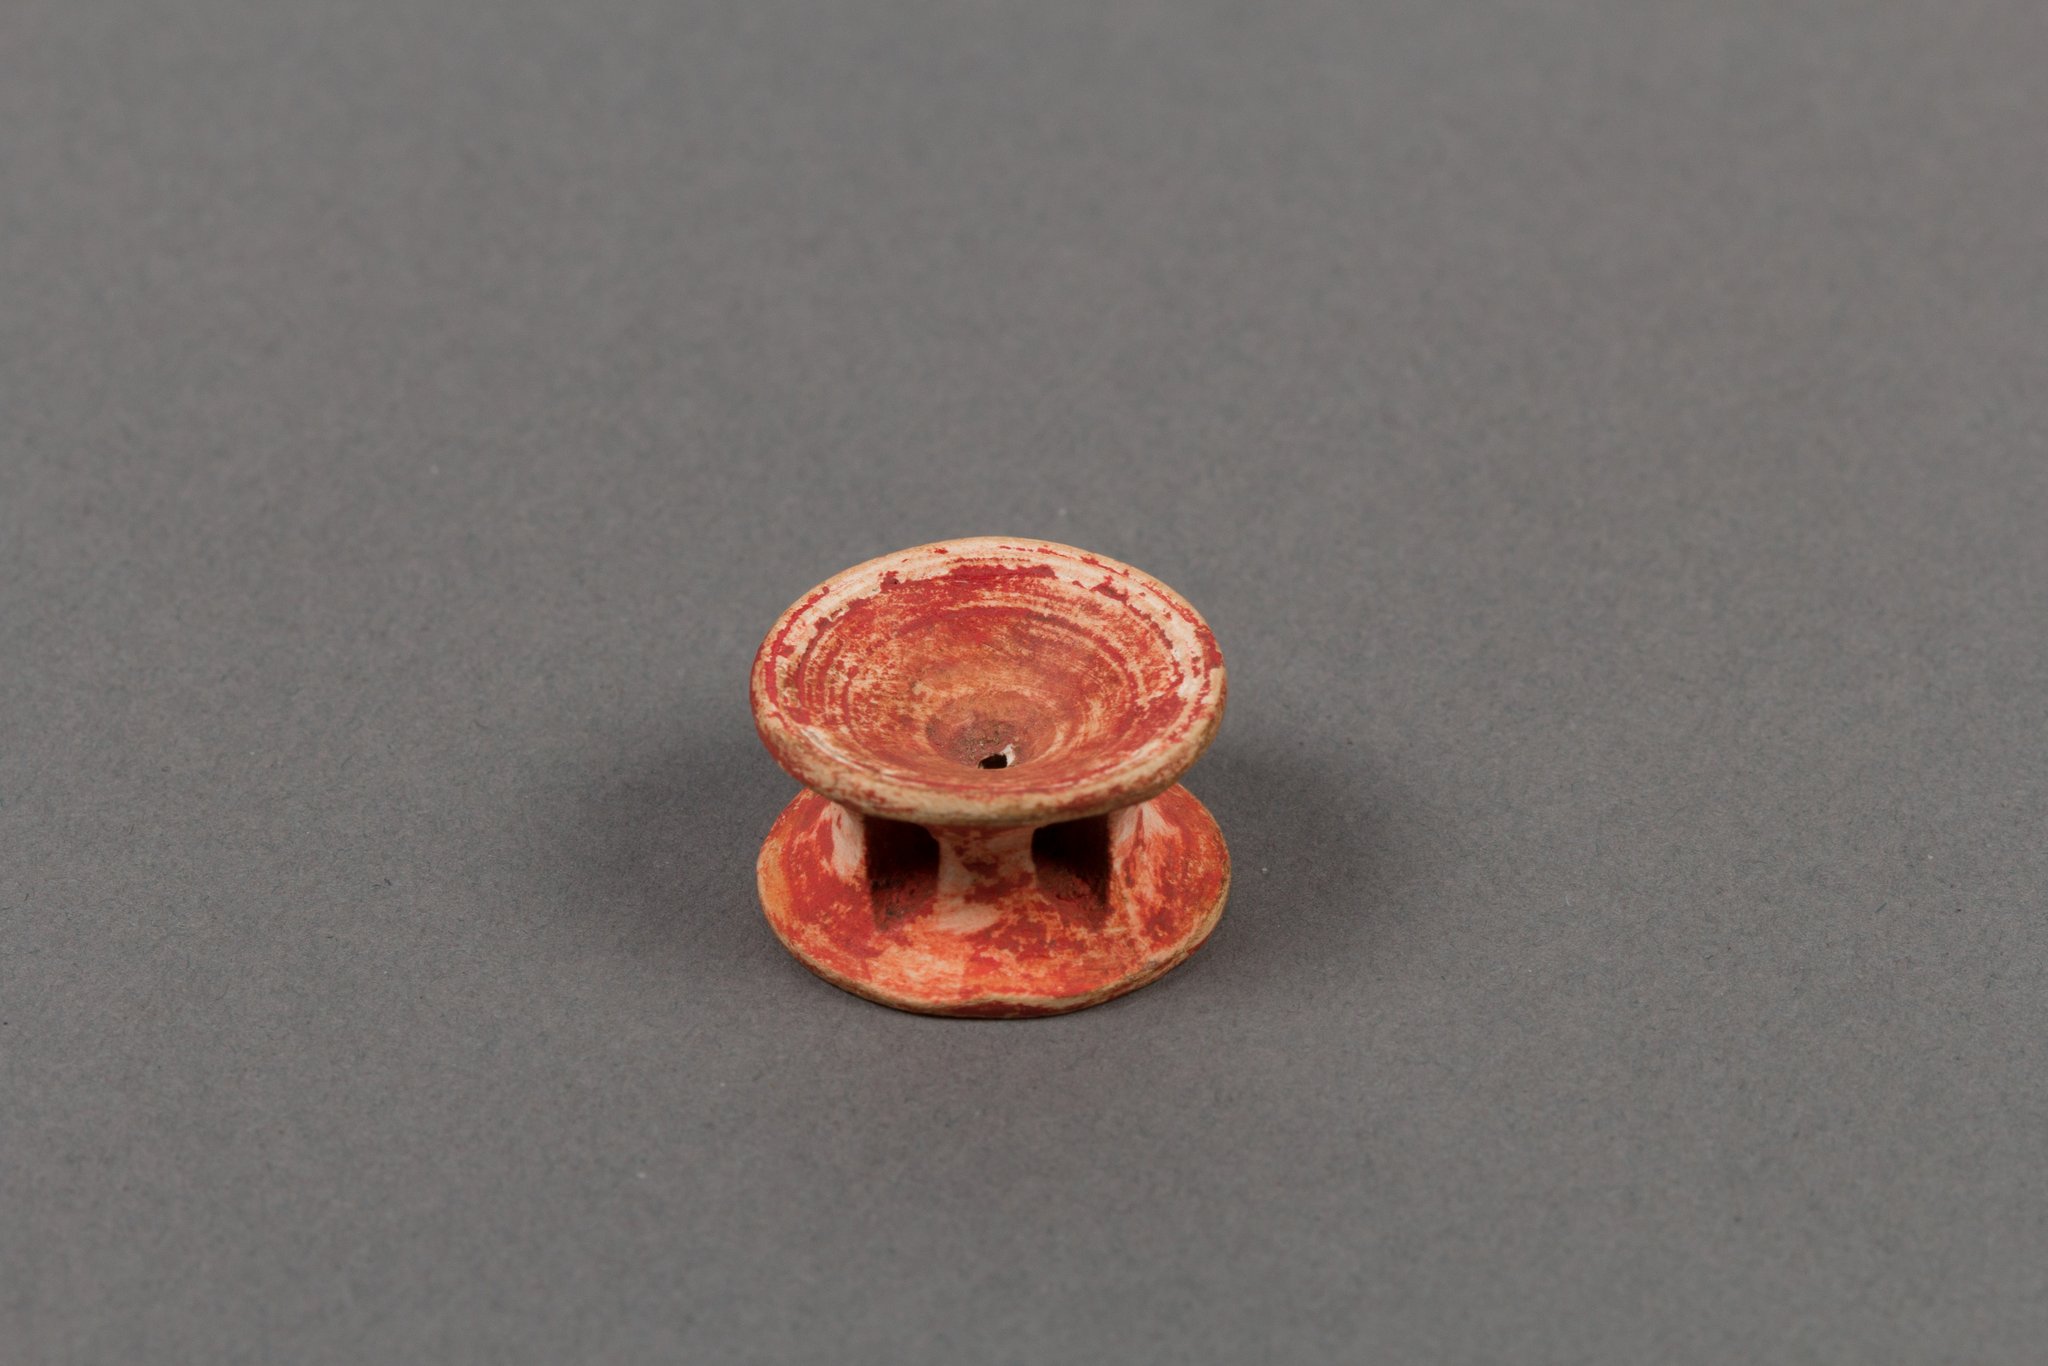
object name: ornament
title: One of a Group of Bone Ornaments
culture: japanese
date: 1000-300 BCE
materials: bone